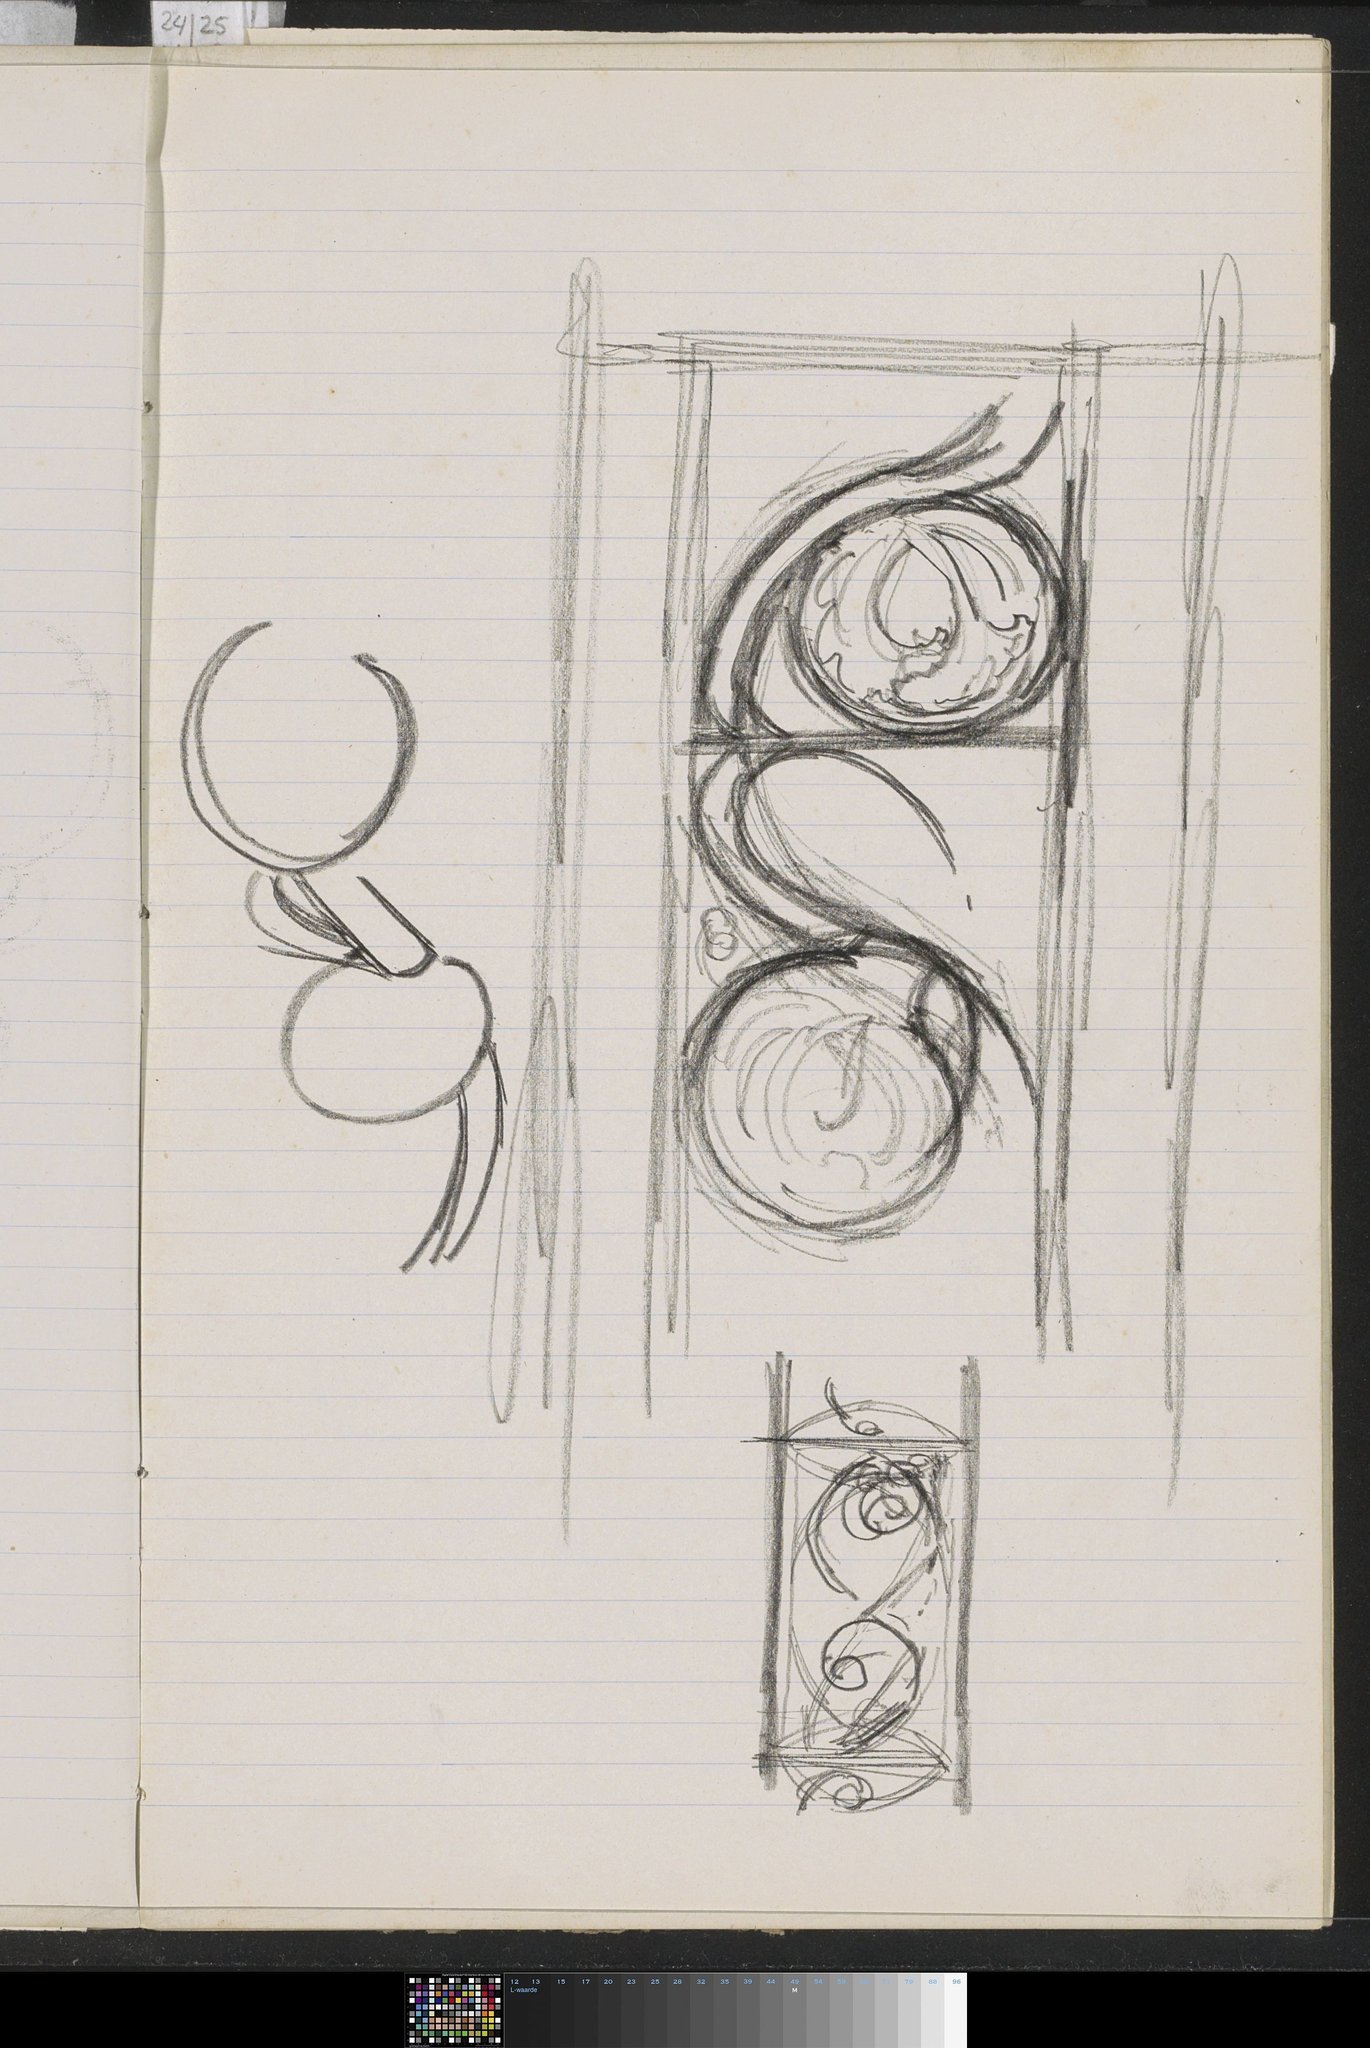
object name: sketchbook leaf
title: Ornamentontwerpen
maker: gerrit willem dijsselhof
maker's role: designer, draughtsman, print maker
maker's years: 1866-1924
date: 1901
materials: chalk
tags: ornaments ~ art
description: Blad 20 recto uit een schetsboek met 79 bladen.